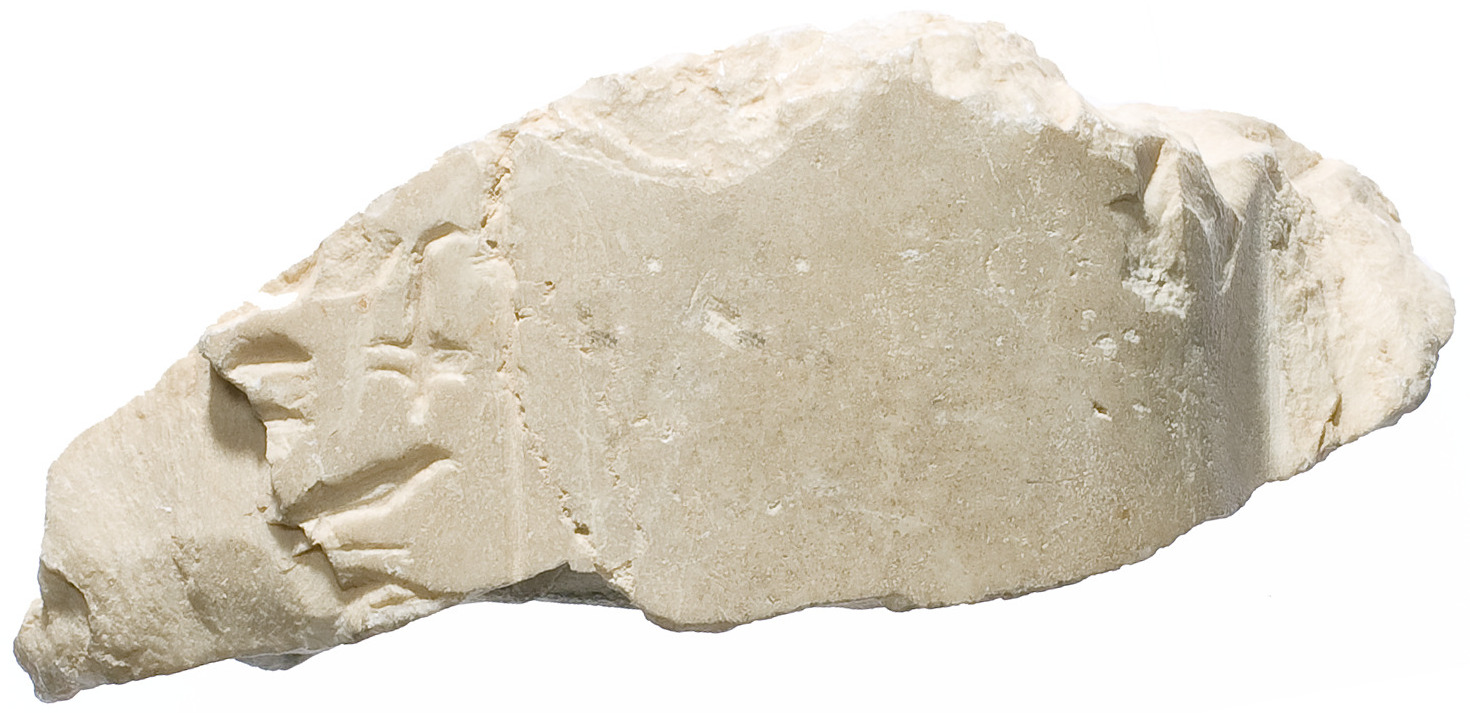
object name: nefertiti head wig fragment, inscribed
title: Wig of Nefertiti, inscribed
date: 1353-1336 BCE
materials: limestone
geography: egypt